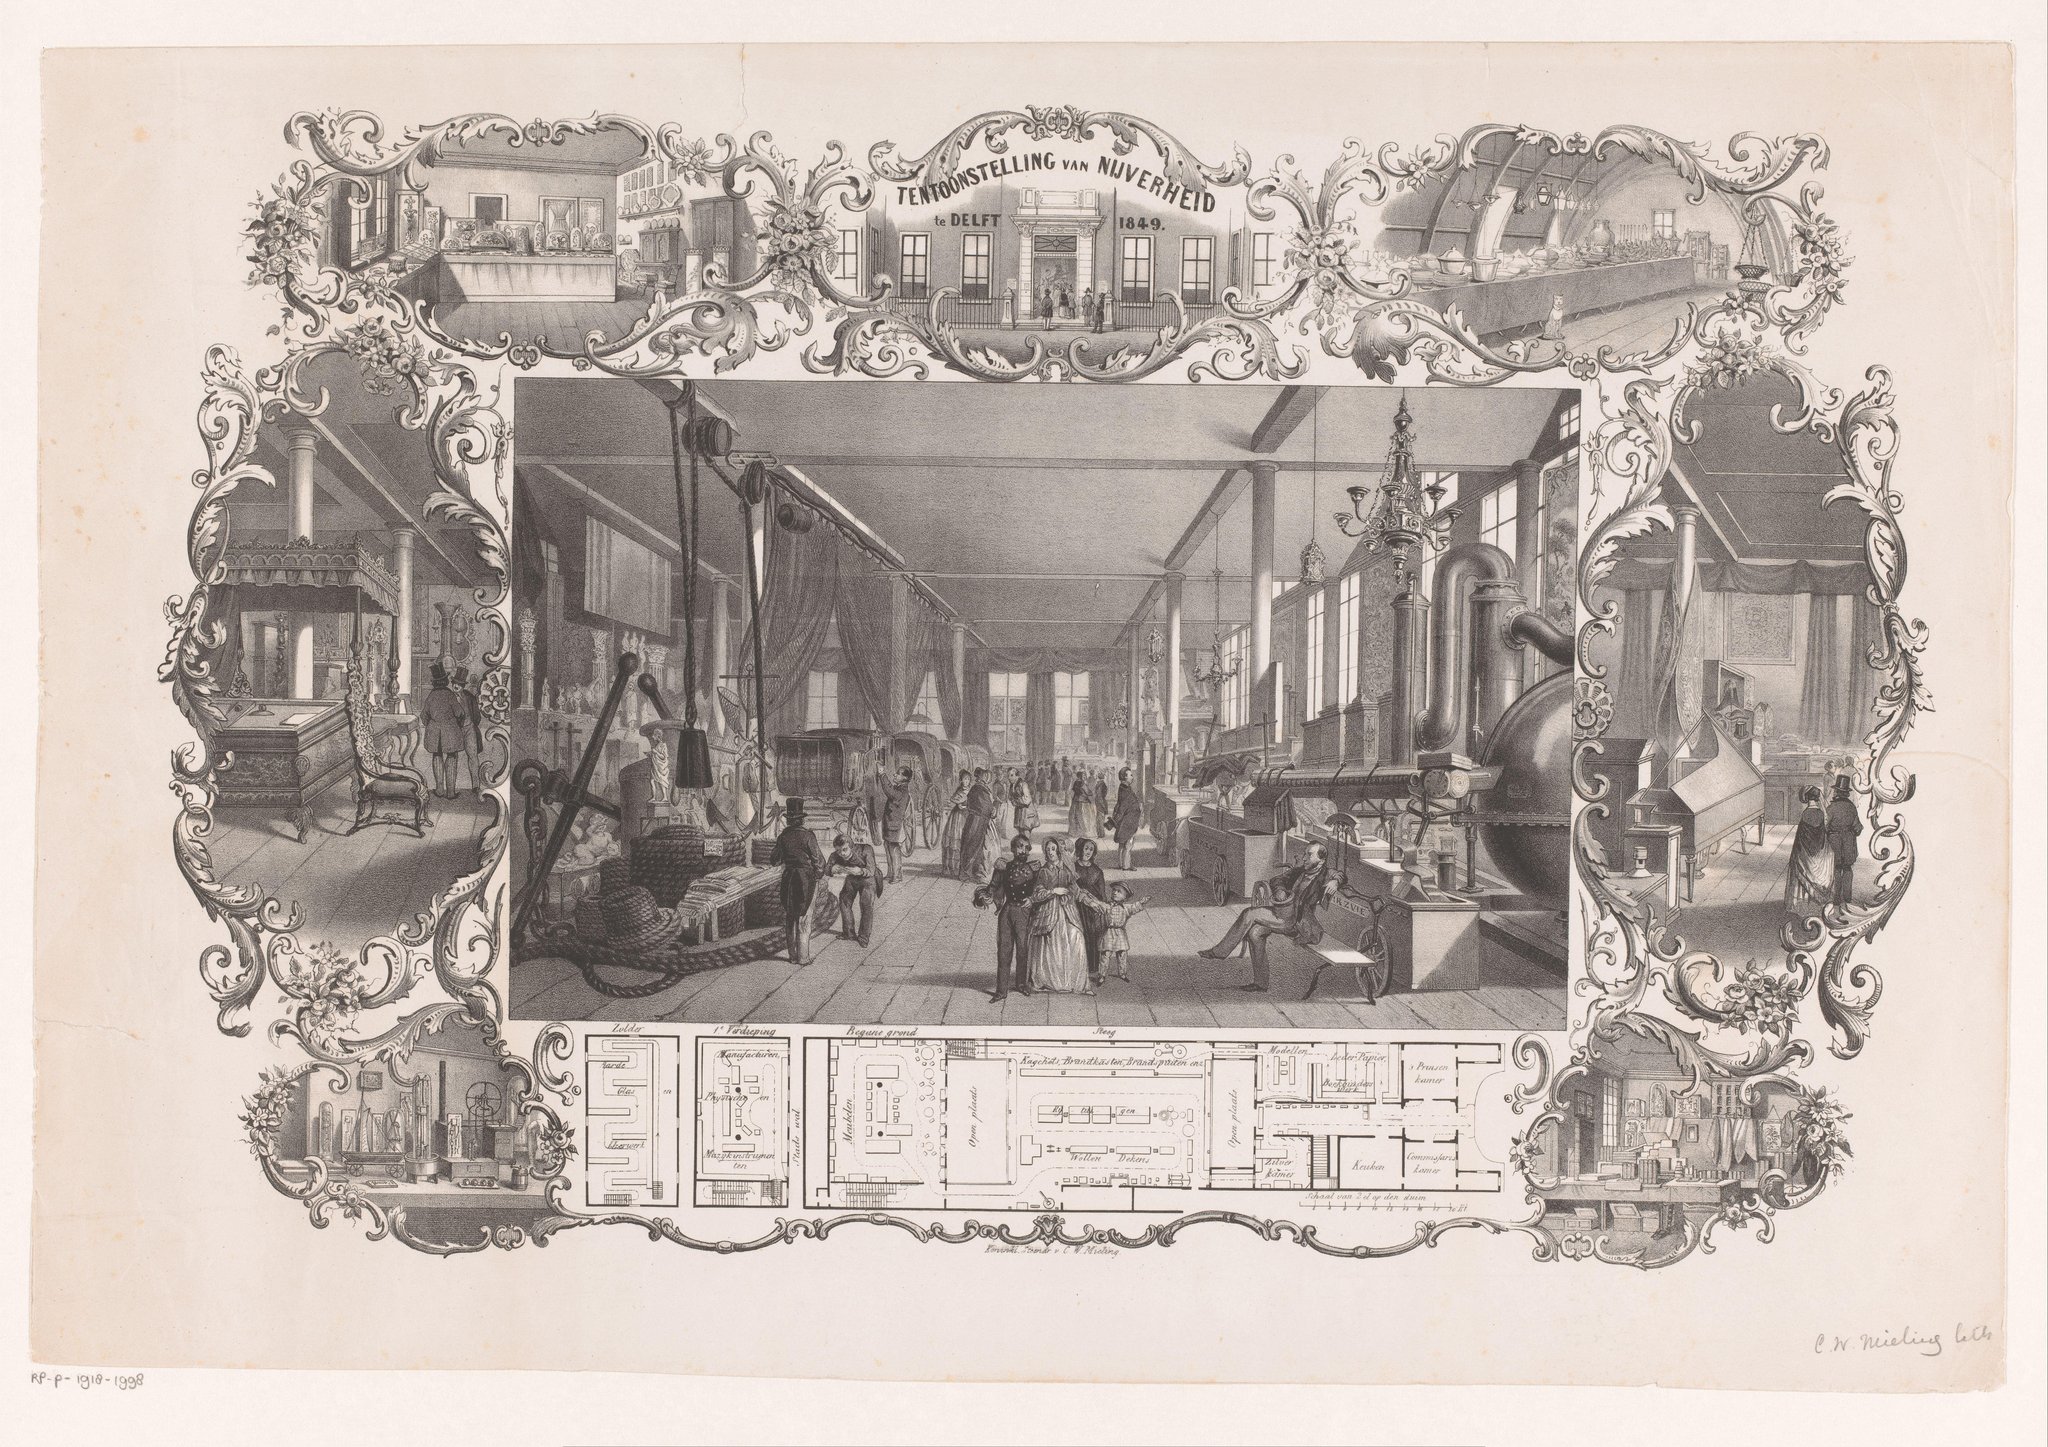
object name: print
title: Tentoonstelling van Nijverheid te Delft 1849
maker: Anonymous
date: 1849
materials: paper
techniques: lithograph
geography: the hague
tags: trade exhibition, industries fair, delft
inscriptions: collector's mark: Lugt 2233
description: Gezicht in de grote zaal van de Tentoonstelling van Nijverheid gehouden in het hoofdgebouw van de 'Koninklijke Akademie ter opleiding van burgerlijke ingenieurs zoo voor 's lands dienst als voor de nijverheid en van kweekelingen voor den handel' te Delft, juli 1849. In de zaal scheepsbenodigdheden, brandspuiten, rijtuigen een (stoom)machine. Om de centrale voorstelling staan zeven gezichten in de andere zalen van de tentoonstelling en een plattegrond van de tentoonstelling.